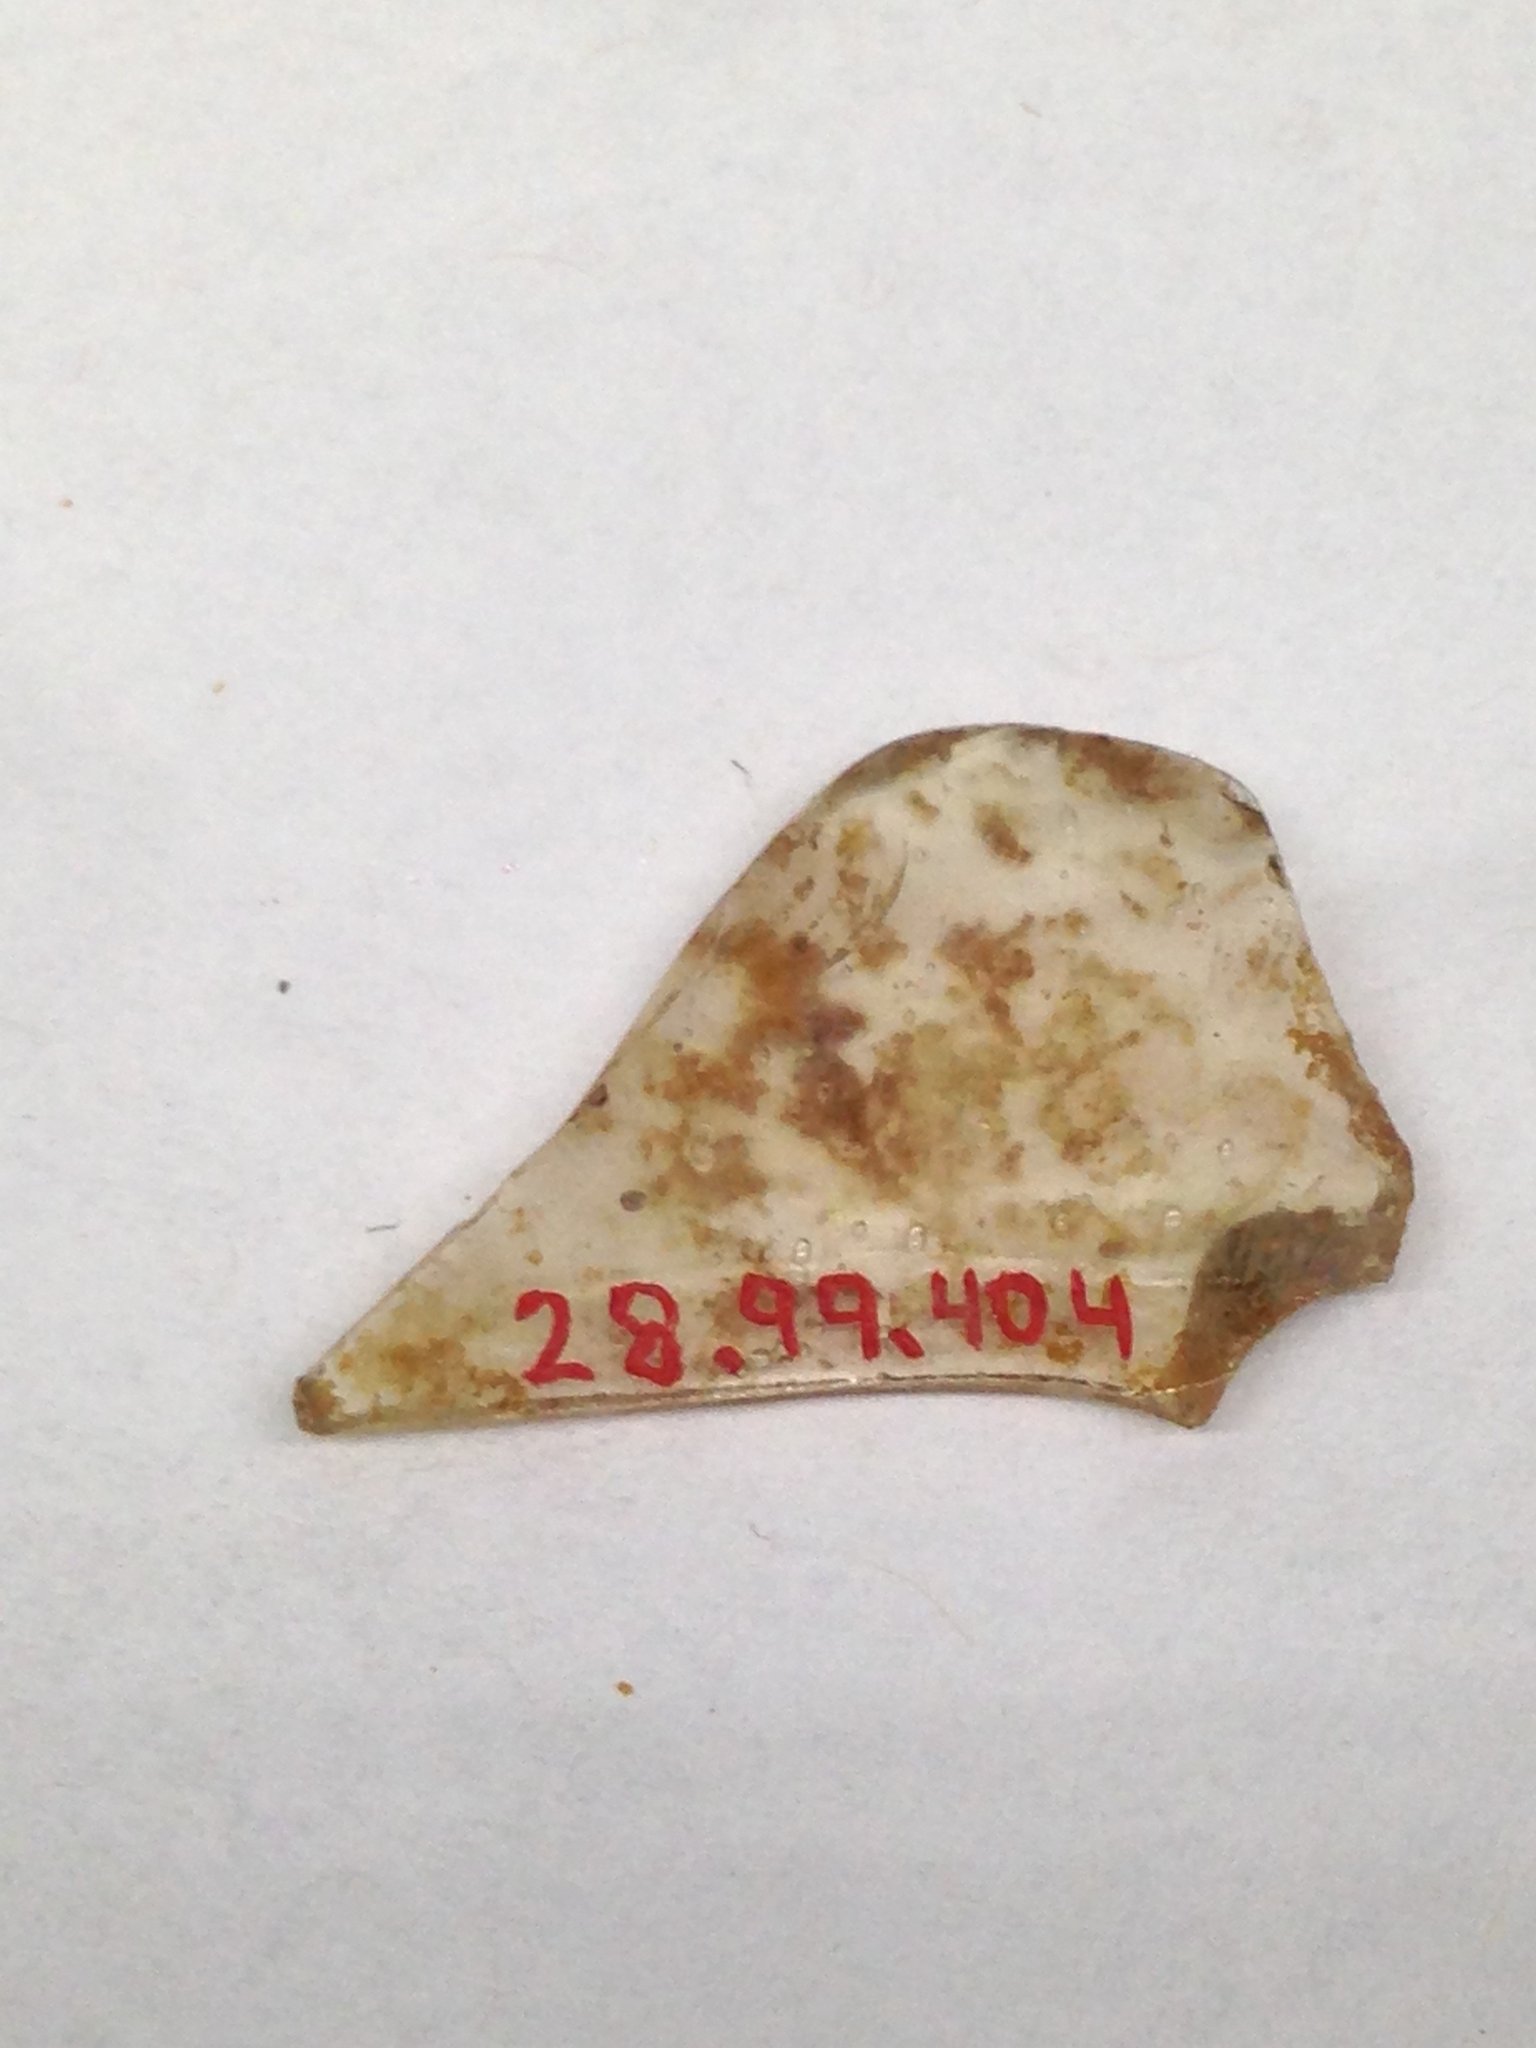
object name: fragment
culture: european or middle eastern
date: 1150-1250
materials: ceramic, glass